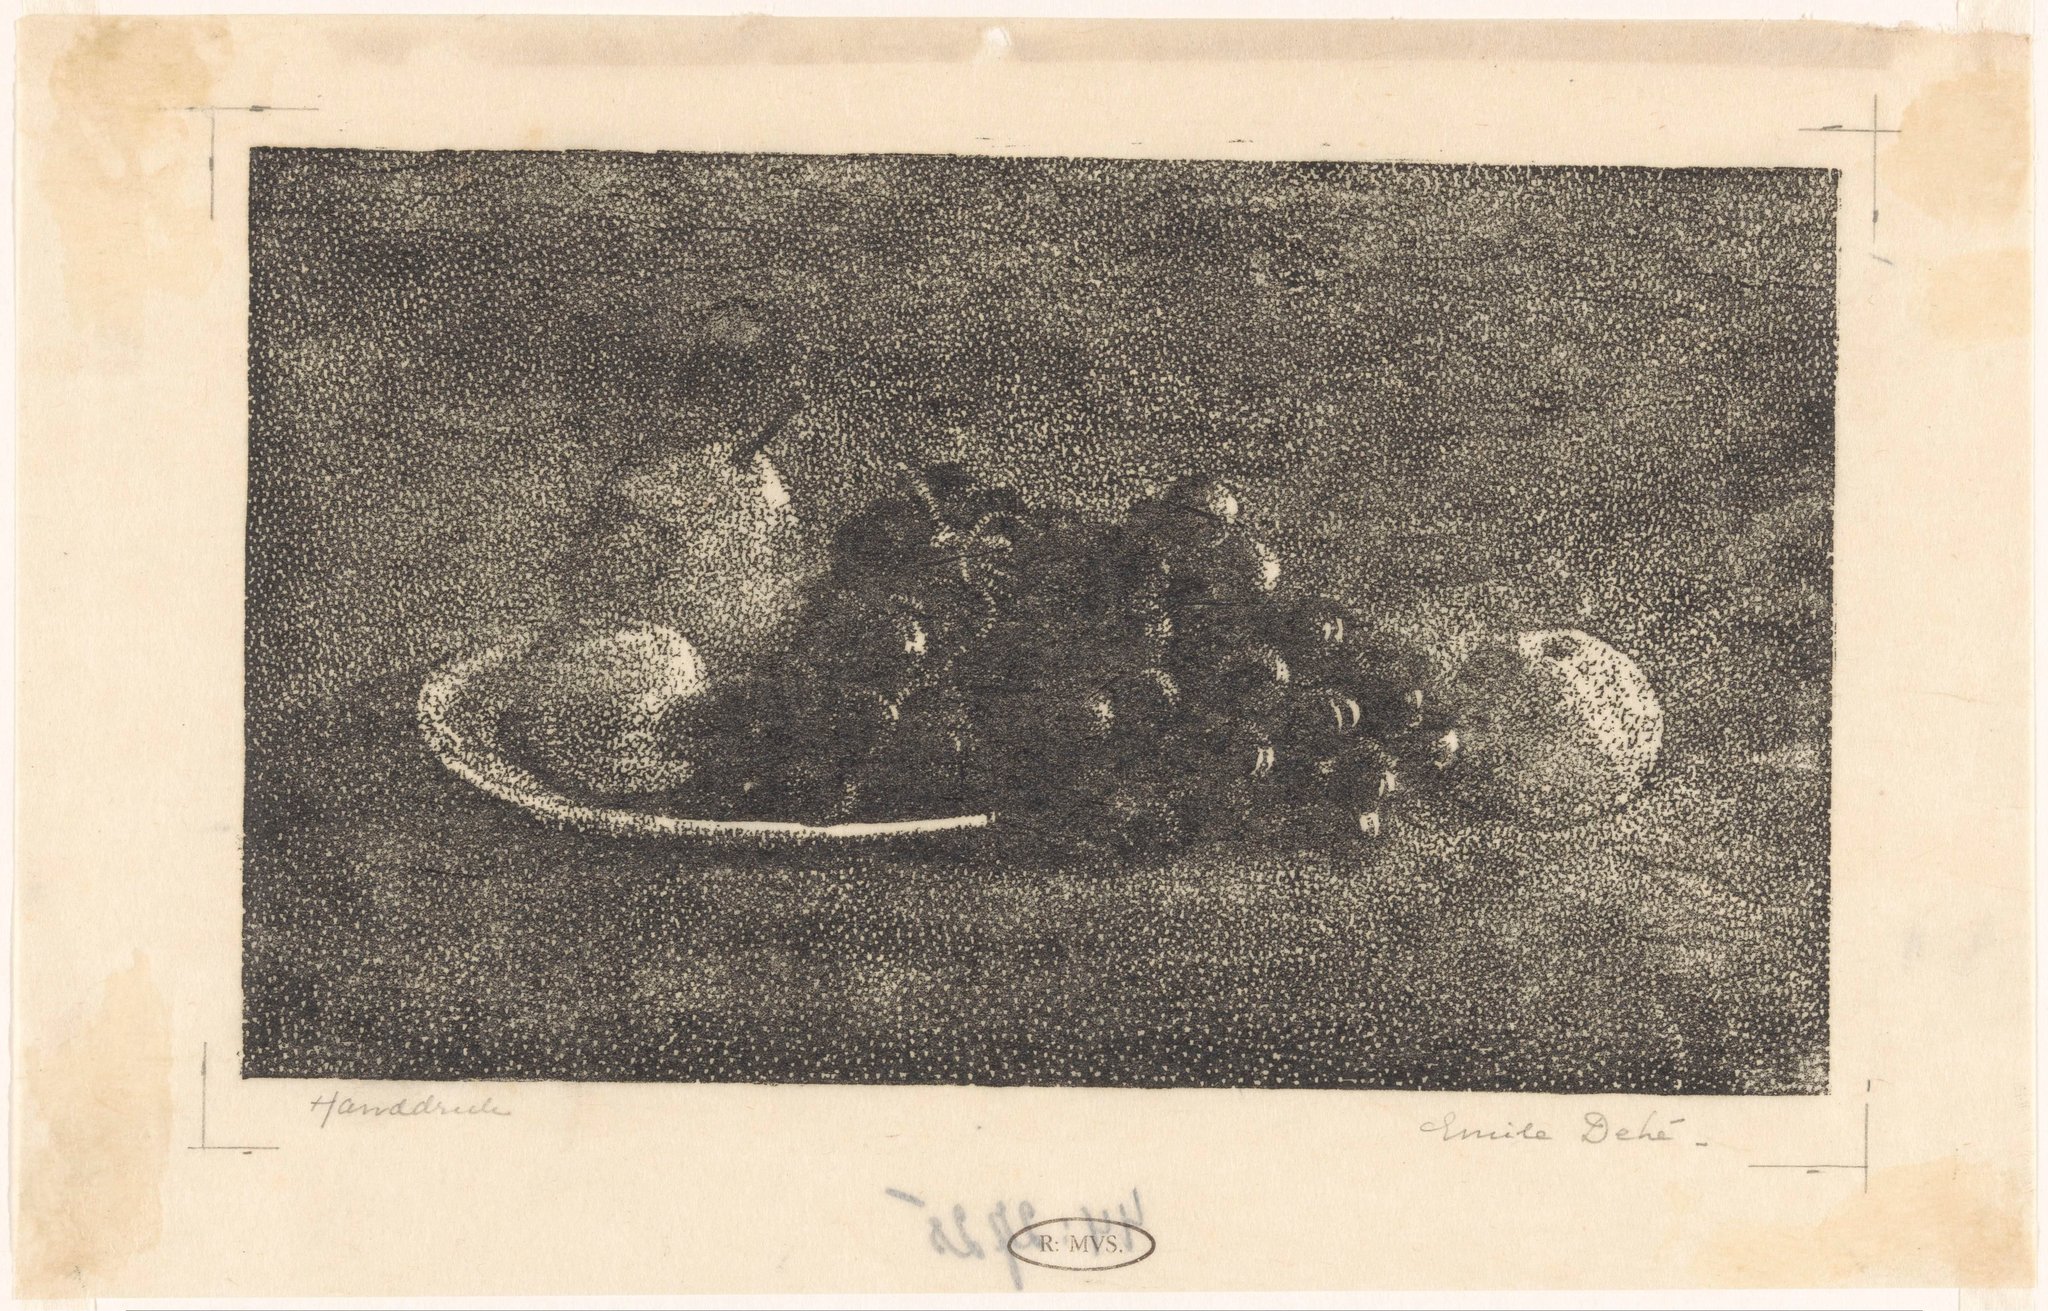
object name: print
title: Schaal met druiven en ander fruit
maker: emilius wilhelmus dehé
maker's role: draughtsman, print maker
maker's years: 1886-1947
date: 1896-1944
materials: paper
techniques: woodcut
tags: fruit, grape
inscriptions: collector's mark: Lugt 2228